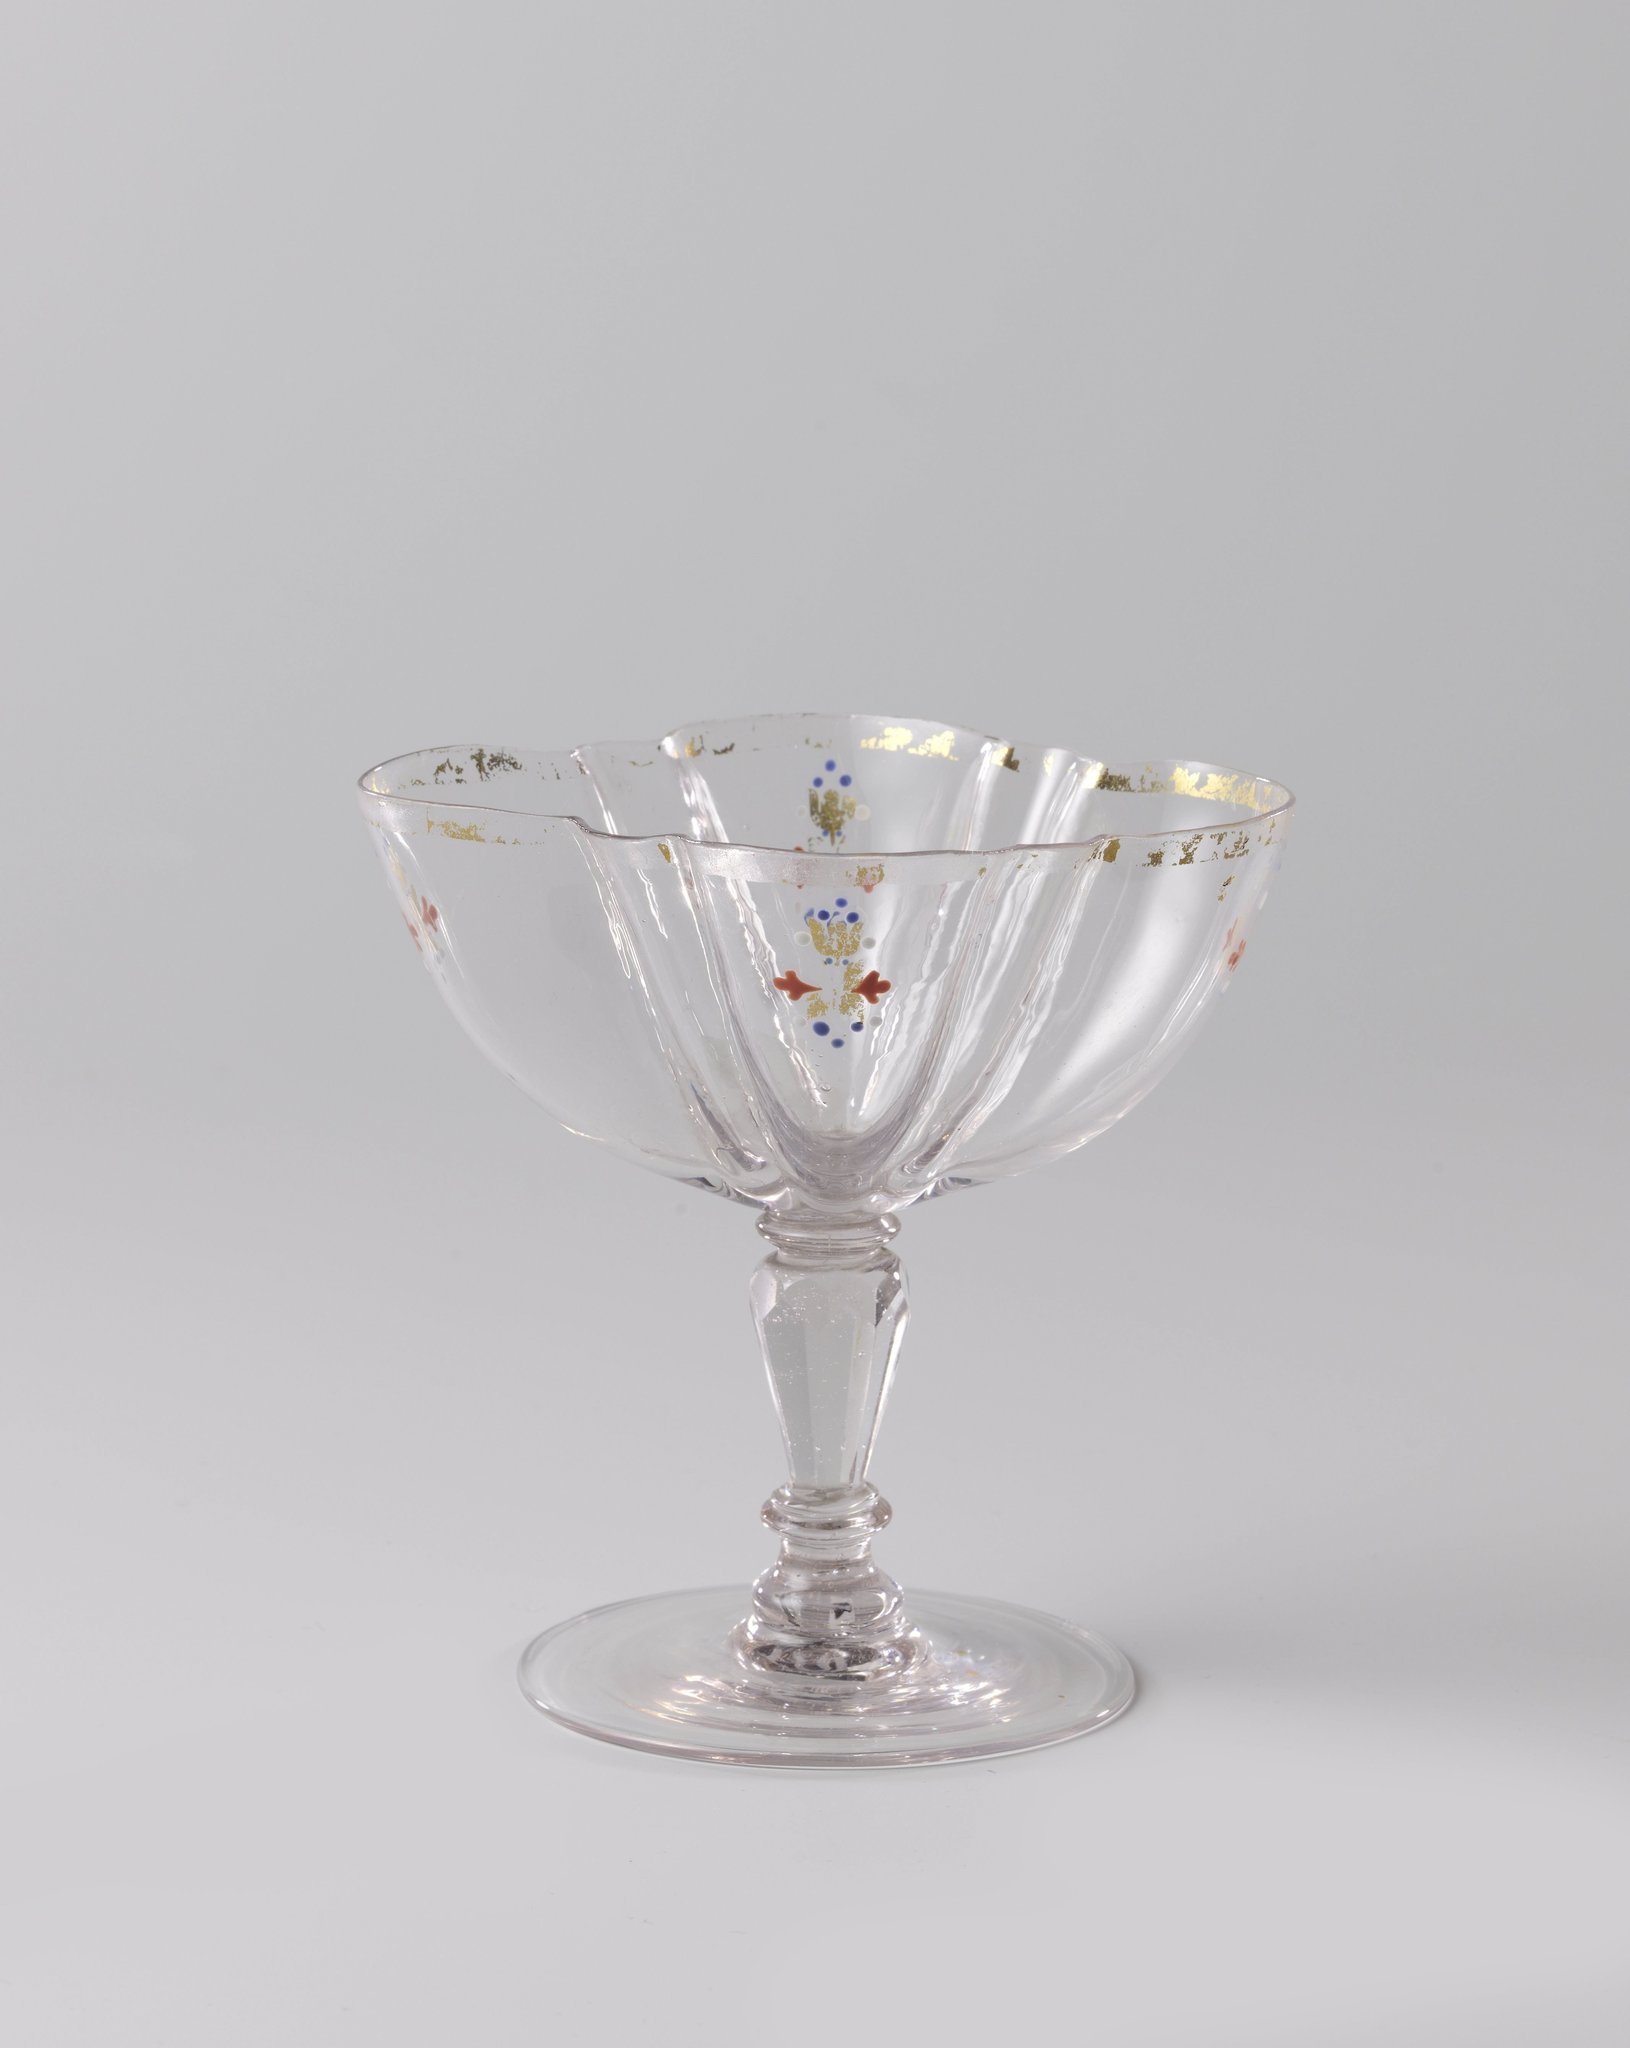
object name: confiturenglas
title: Schaal op voet met bloemtakken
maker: Anonymous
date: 1725-1750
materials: glass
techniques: glassblowing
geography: silesia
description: Platte voet, balustervormige, in facetten geslepen stam, vierlobbige, ovale kelk met vier bloemtakjes in rood, blauw, wit en verguld, langs de bovenrand een verguld biesje.